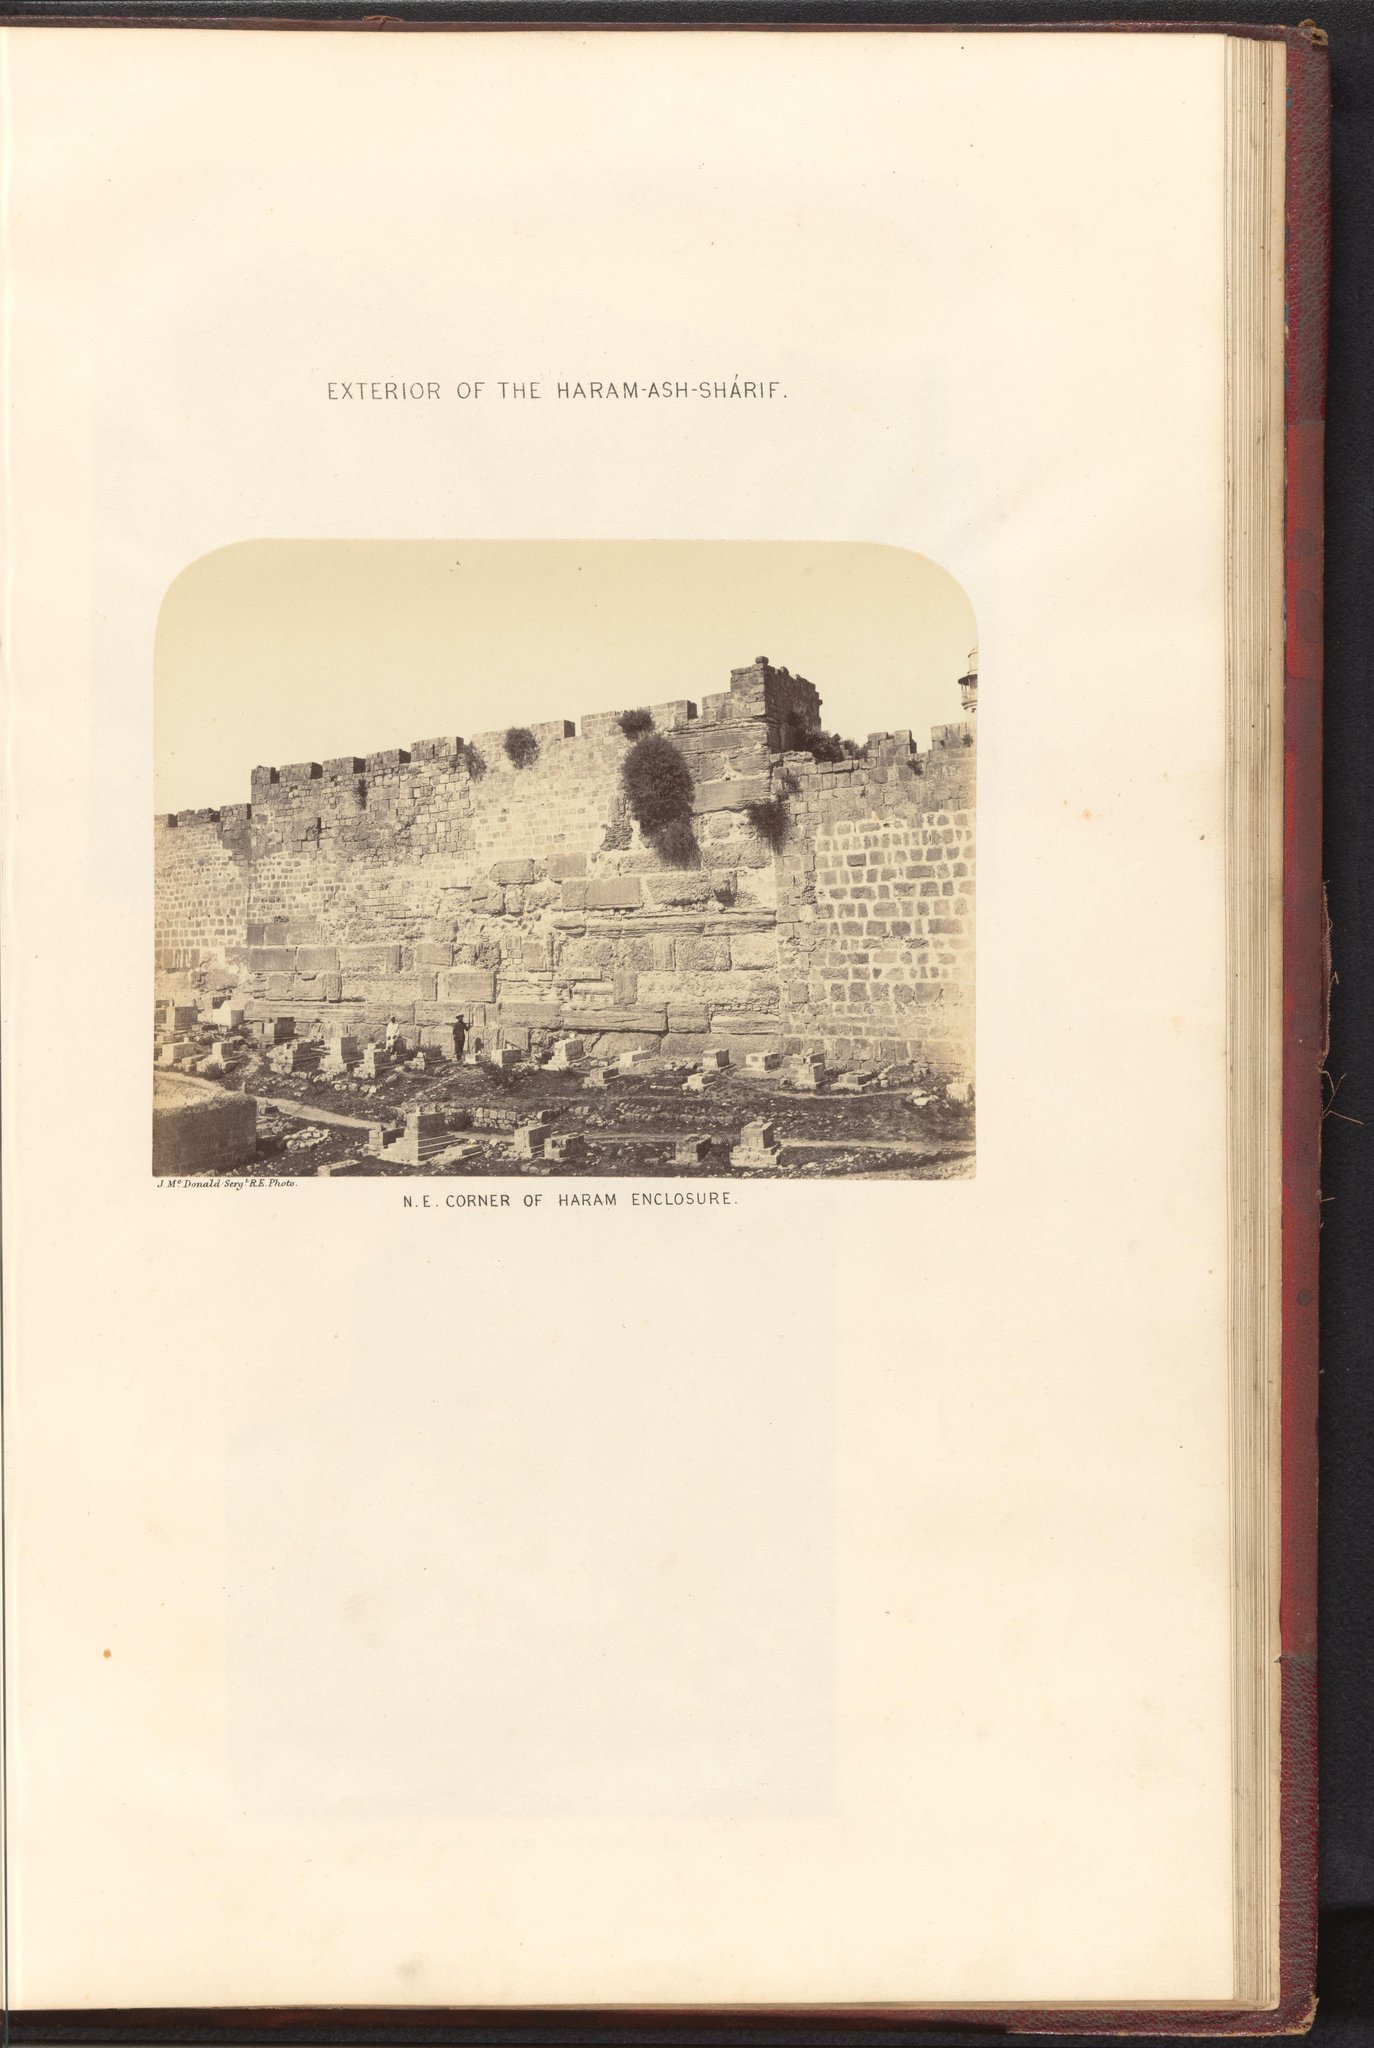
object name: photograph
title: Gezicht op de noordoostelijke hoek van de Tempelberg in Jeruzalem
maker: james mcdonald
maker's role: fotograaf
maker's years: 1822-1885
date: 1860-1865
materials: paper, photographic support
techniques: albumen print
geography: tempelberg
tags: city-walls